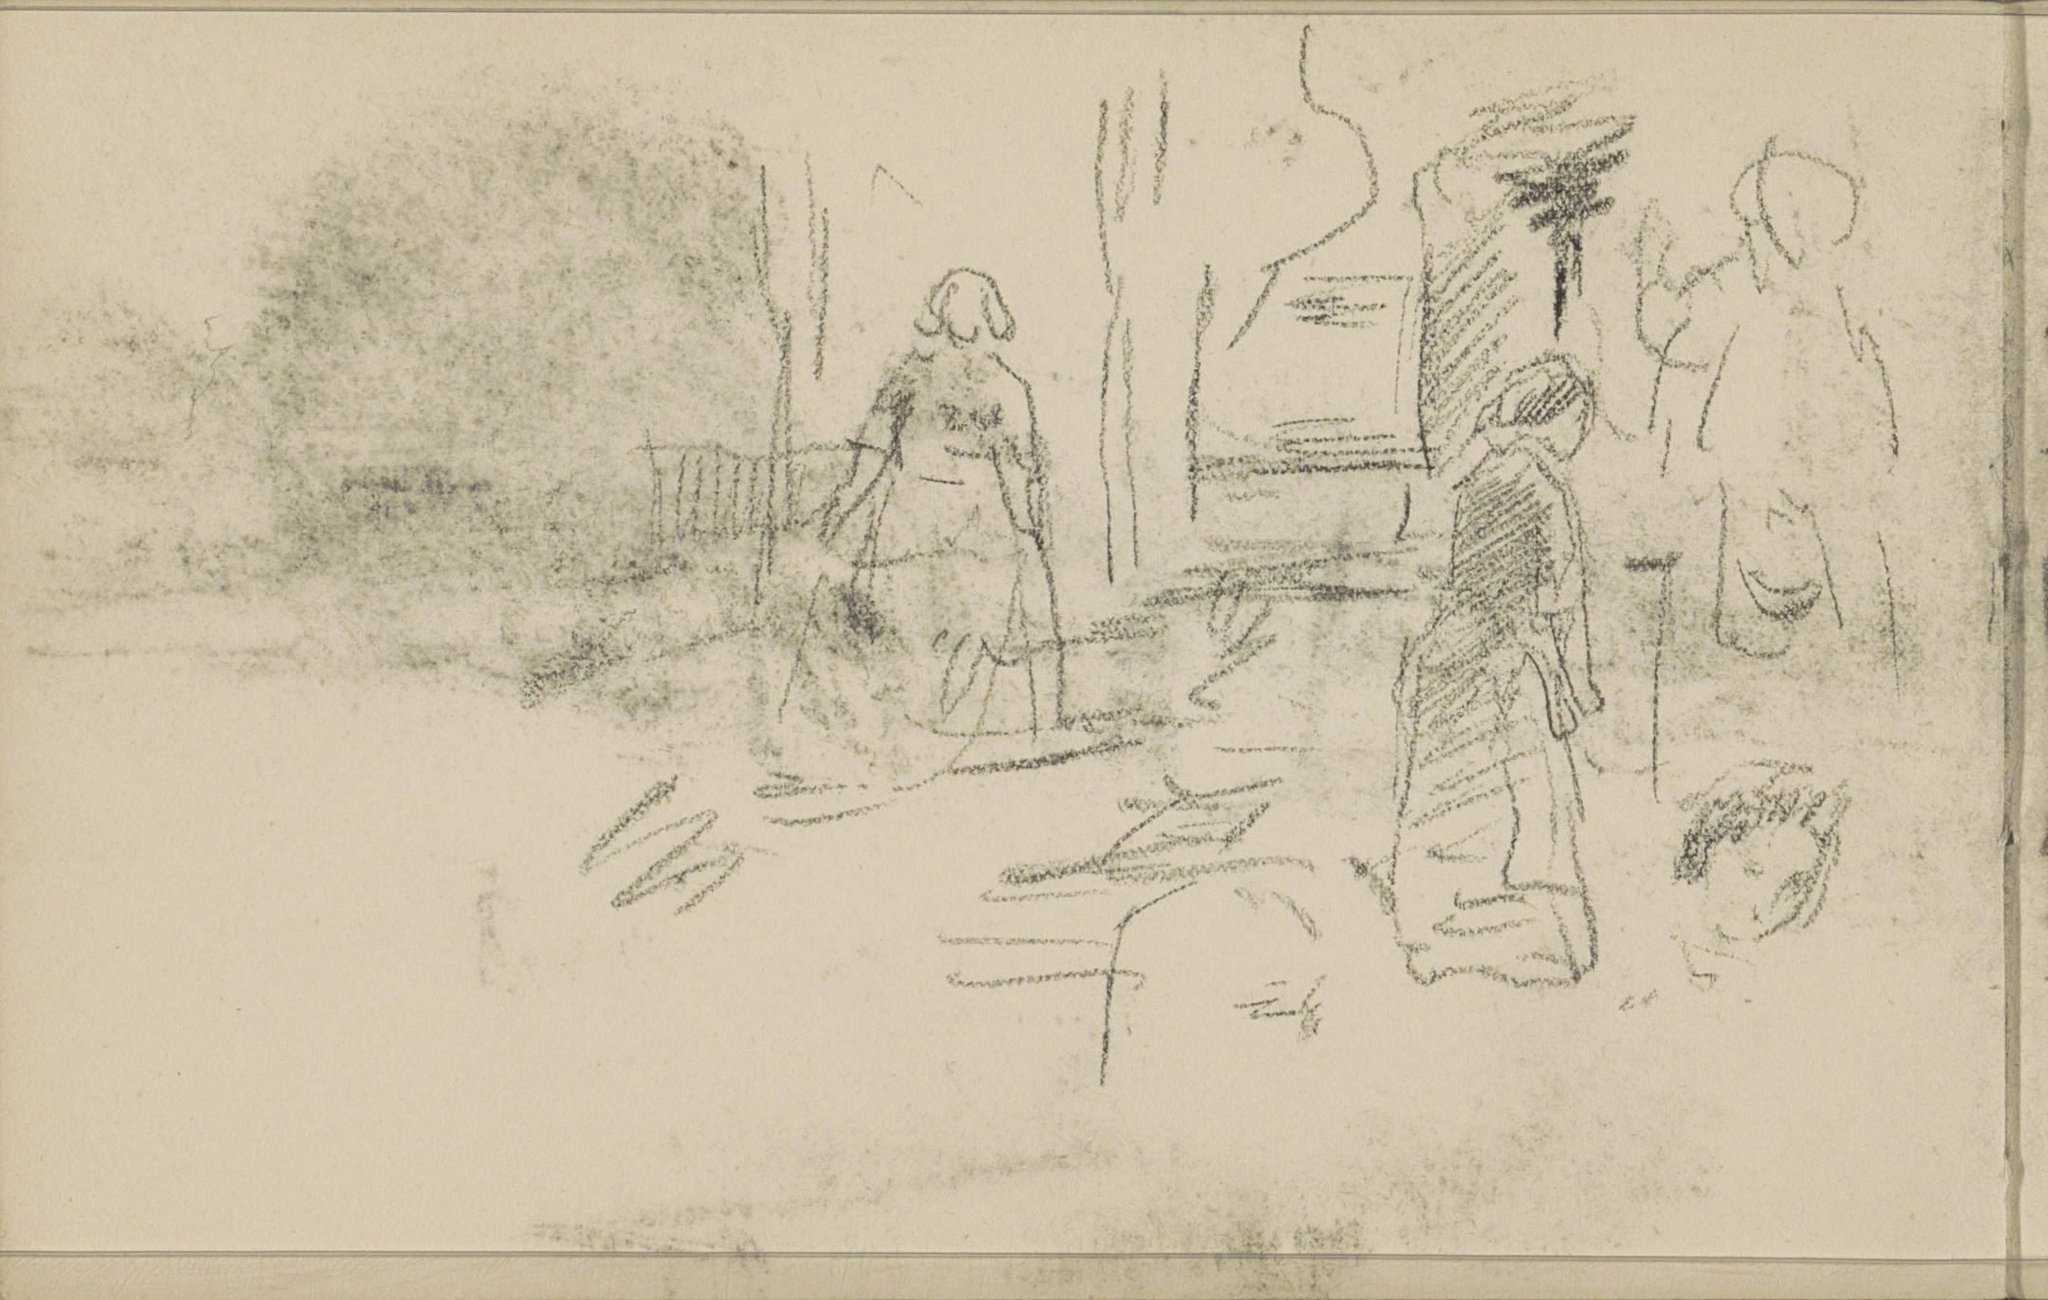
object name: sketchbook leaf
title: Studieblad met vrouwen, mogelijk boerinnen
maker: johan antonie de jonge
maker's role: draughtsman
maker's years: 1864-1927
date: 1909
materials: chalk, paper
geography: south holland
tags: adult woman, farmers - aa - female farmer, farmer's wife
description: Studieblad met vrouwen, mogelijk boerinnen. Blad 7 verso uit een schetsboek met 31 bladen.